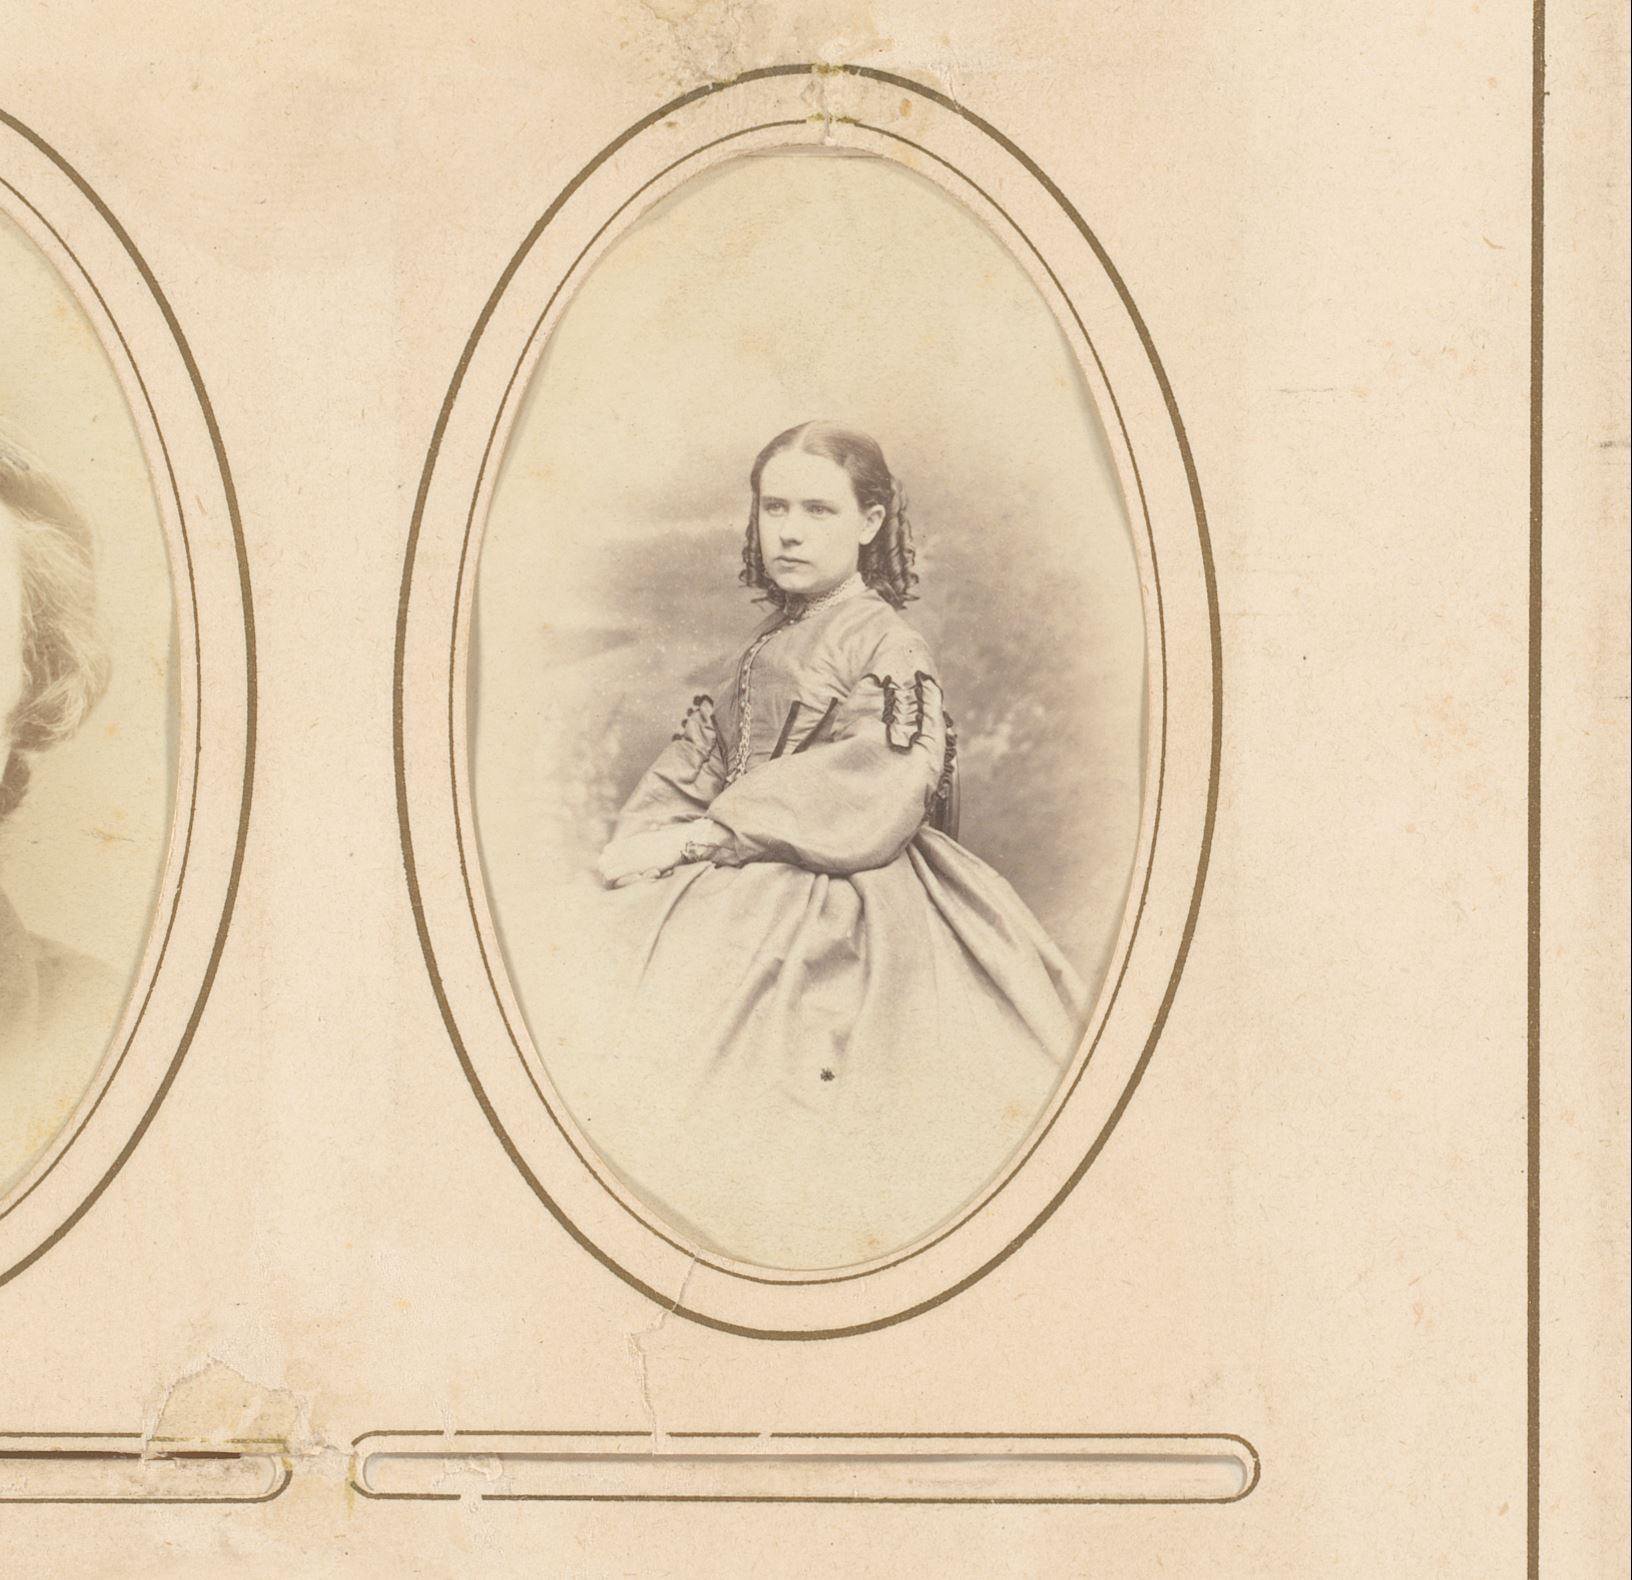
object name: photograph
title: Portret van een meisje met pijpenkrullen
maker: Anonymous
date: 1860-1875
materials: cardboard, paper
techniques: albumen print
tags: historical persons, girl (child between toddler and youth)